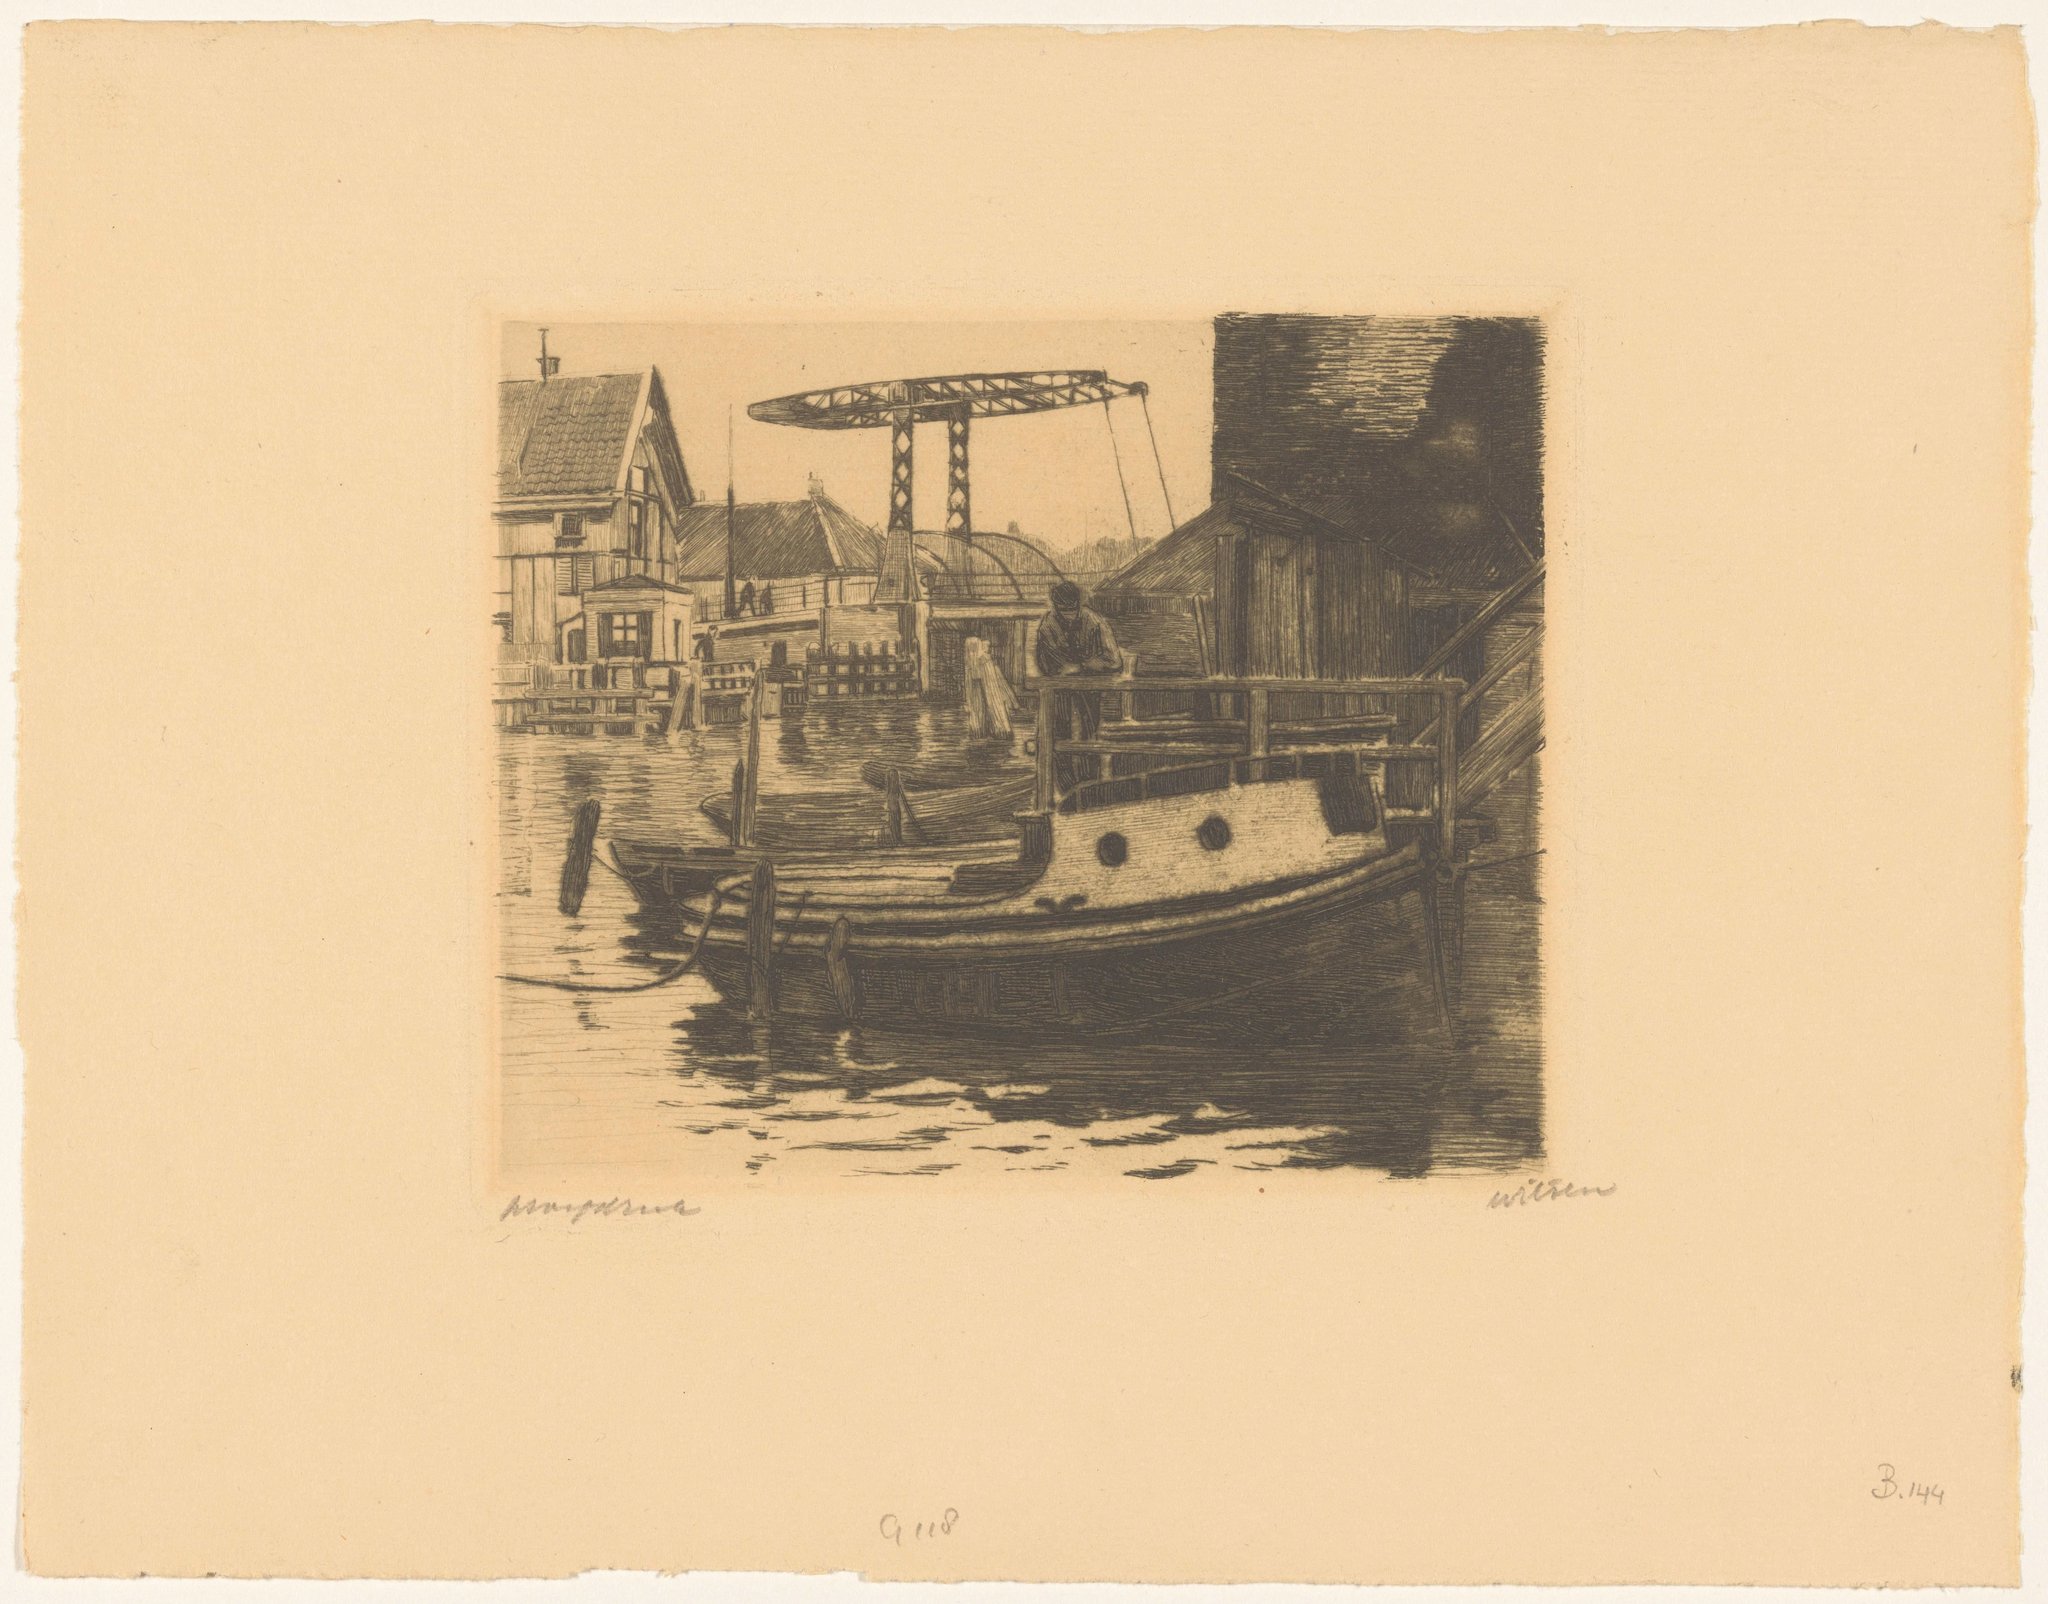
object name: print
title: Gezicht op de ophaalbrug tussen de Kalkmarkt en het 's Gravenhekje in Amsterdam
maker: willem witsen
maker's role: draughtsman, painter, print maker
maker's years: 1860-1923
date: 1911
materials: paper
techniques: etching, intaglio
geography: amsterdam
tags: city-view in general; 'veduta', canals, waters (in city), bridge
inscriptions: signature: ‘Witsen’, watermark, inscription: ‘proefdruk’